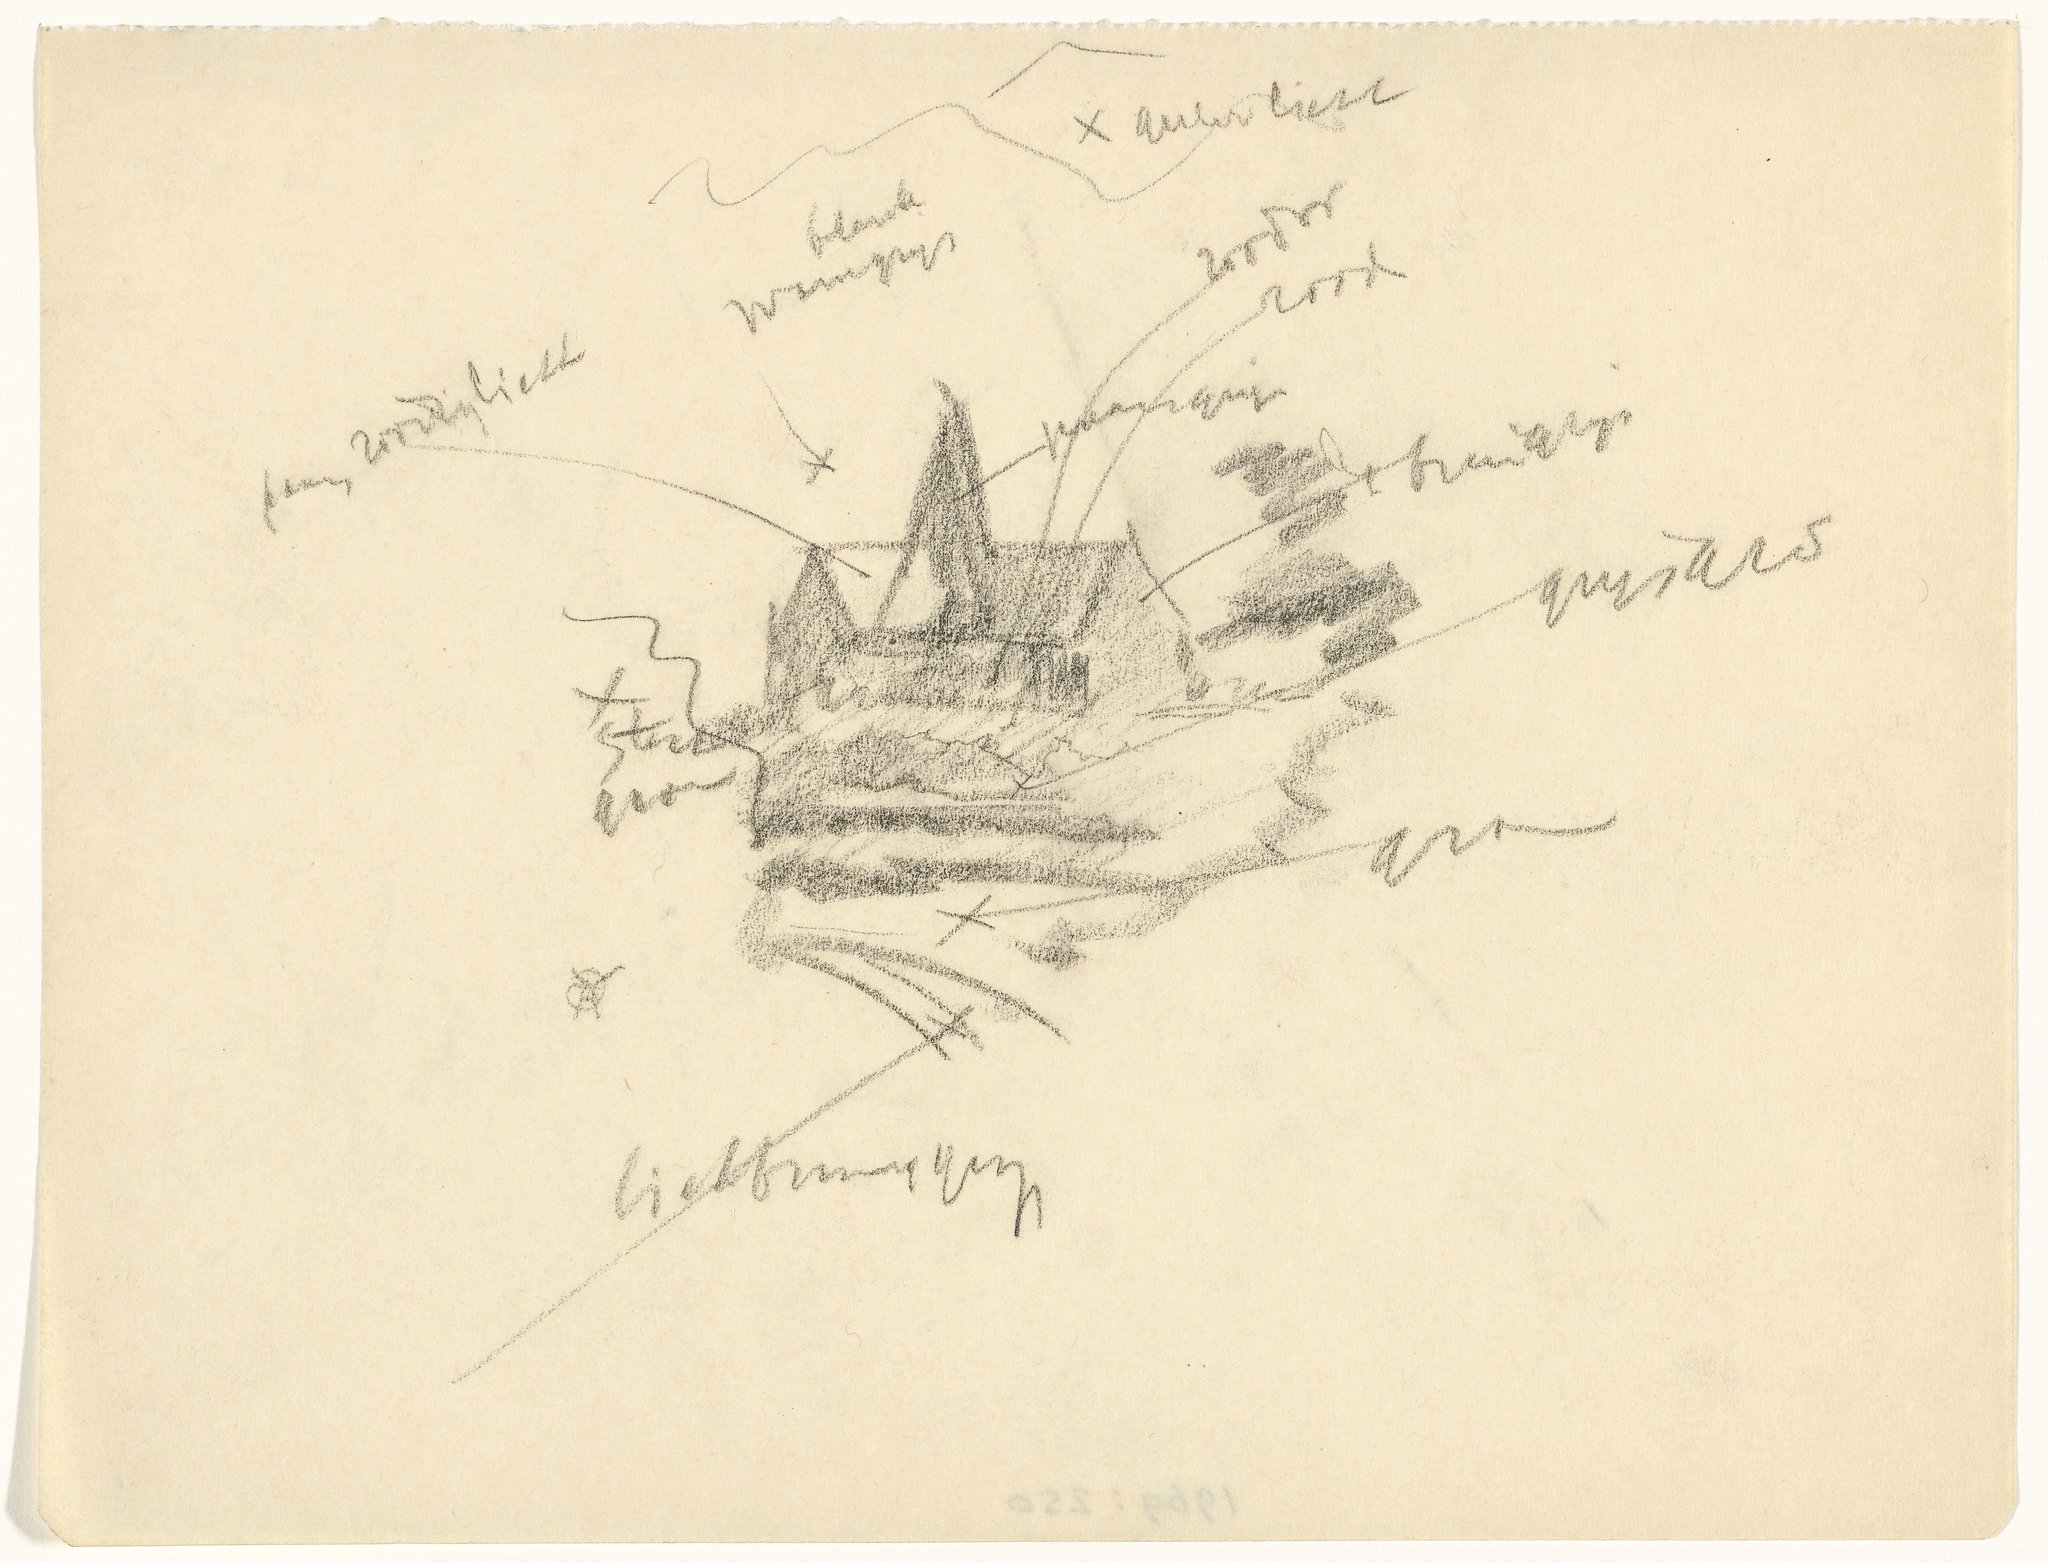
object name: drawing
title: Kerk, met kleurnotities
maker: gerrit willem dijsselhof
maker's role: designer, draughtsman, print maker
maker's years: 1866-1924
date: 1876-1924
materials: chalk, paper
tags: church (exterior)